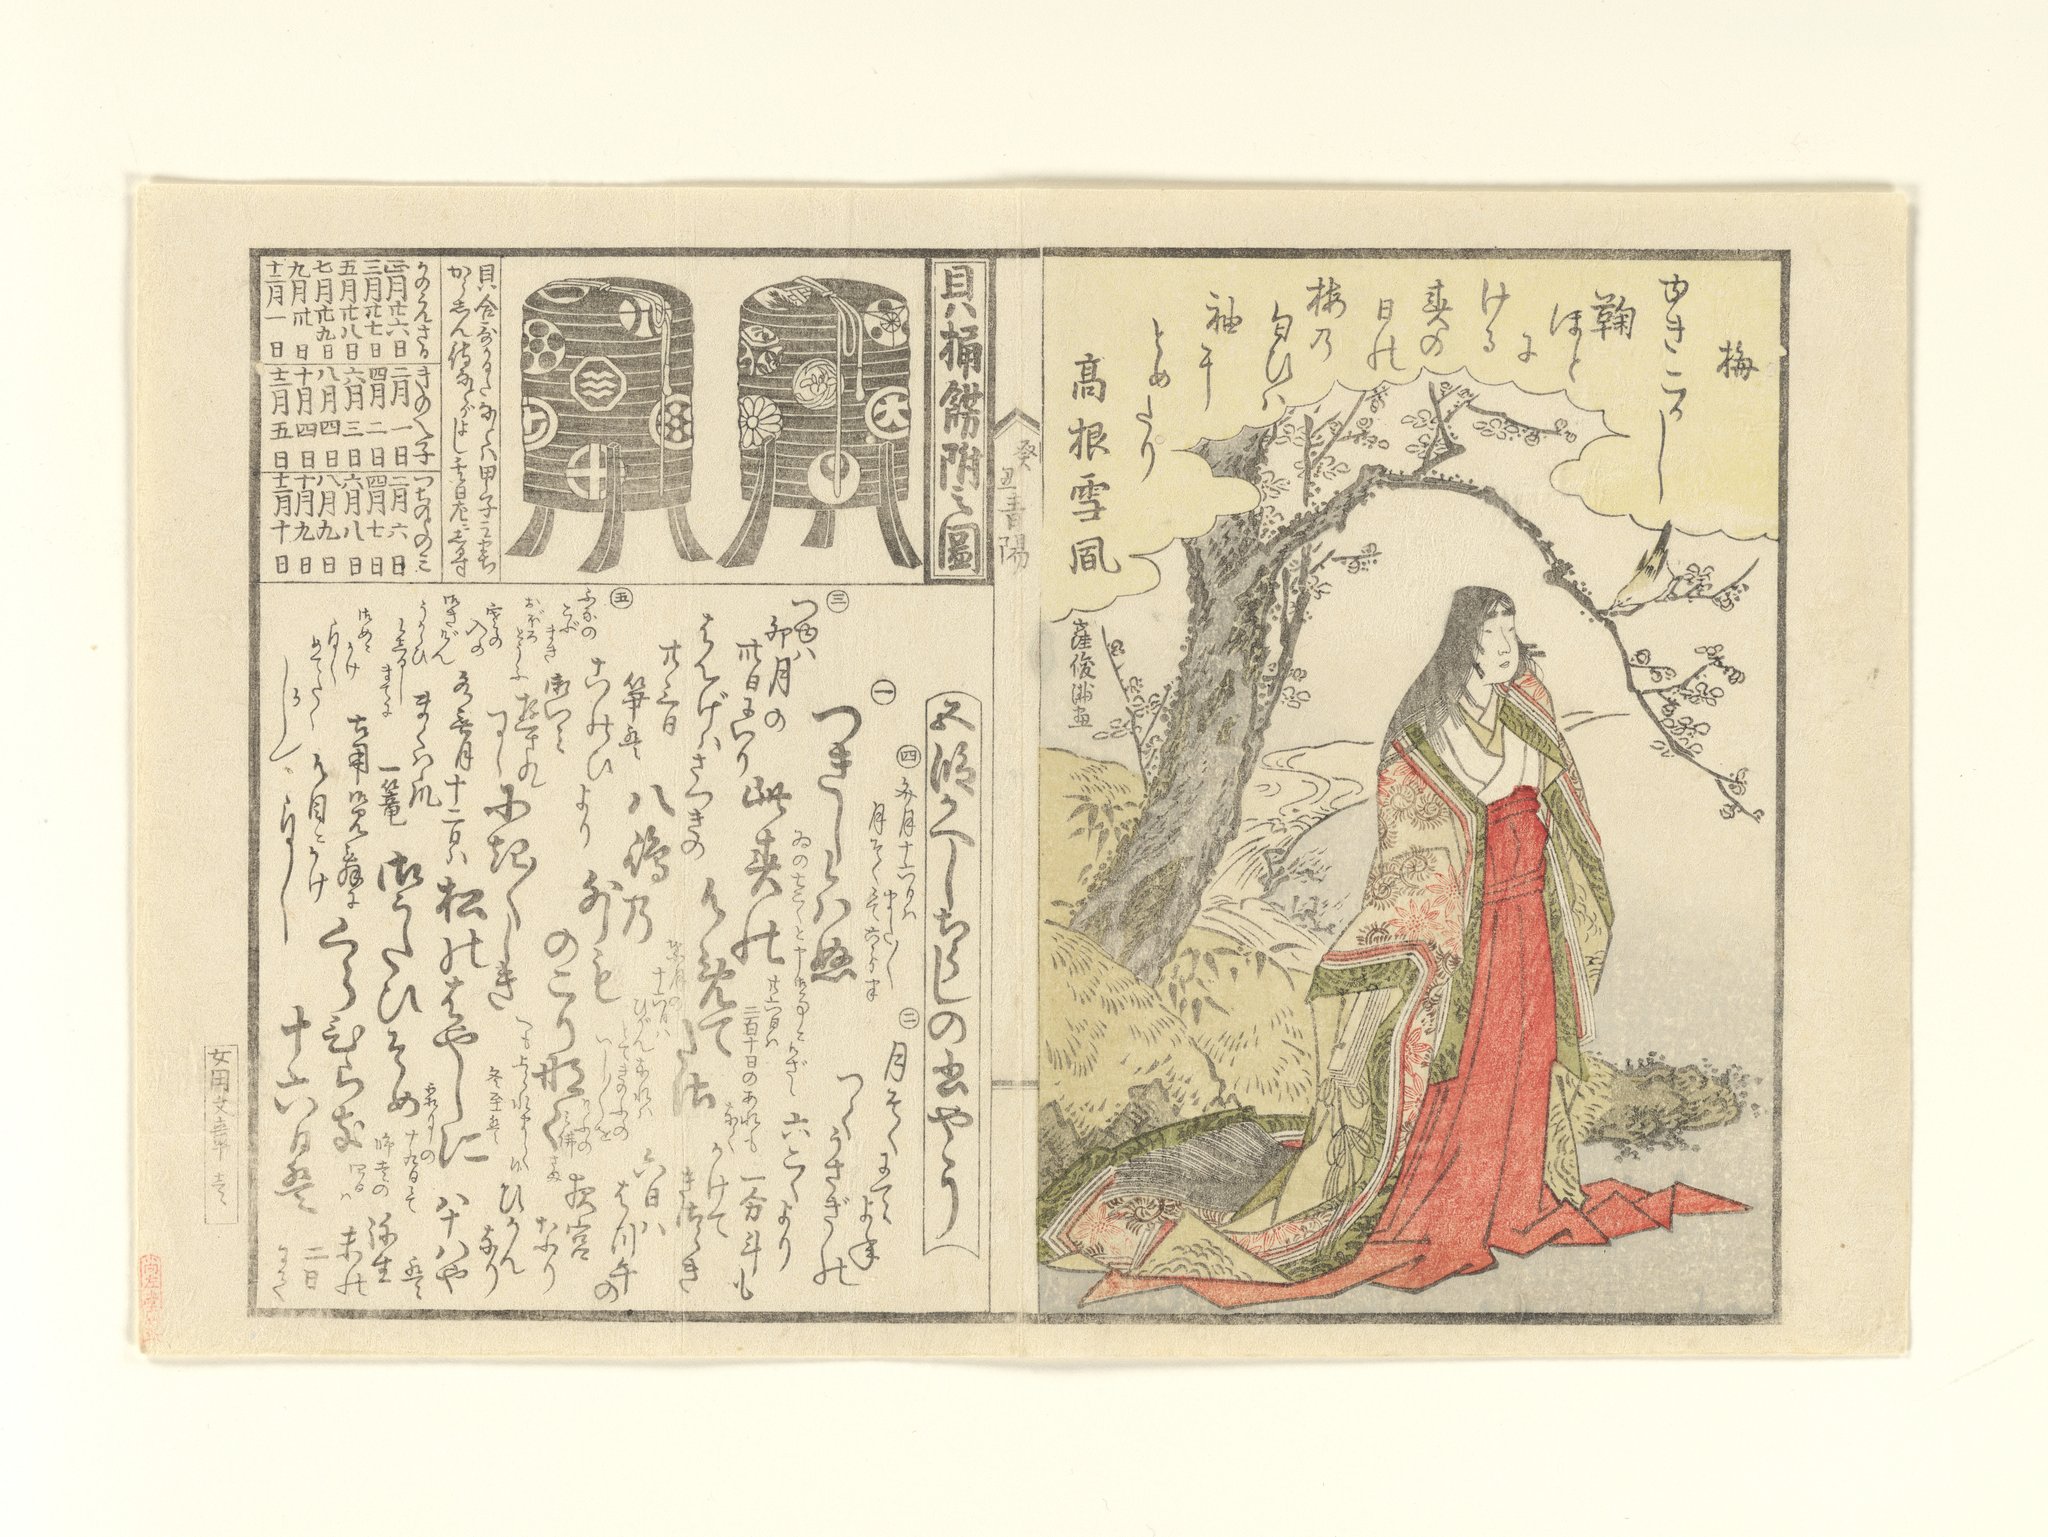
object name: print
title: Court Lady Beneath an Old Plum Tree; Two Lacquer Cabinets for the Shell-matching Game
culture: japanese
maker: kubo shunman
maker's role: artist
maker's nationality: japanese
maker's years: 1757-1820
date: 1793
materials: ink, paper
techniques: surimono, woodblock print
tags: women,trees